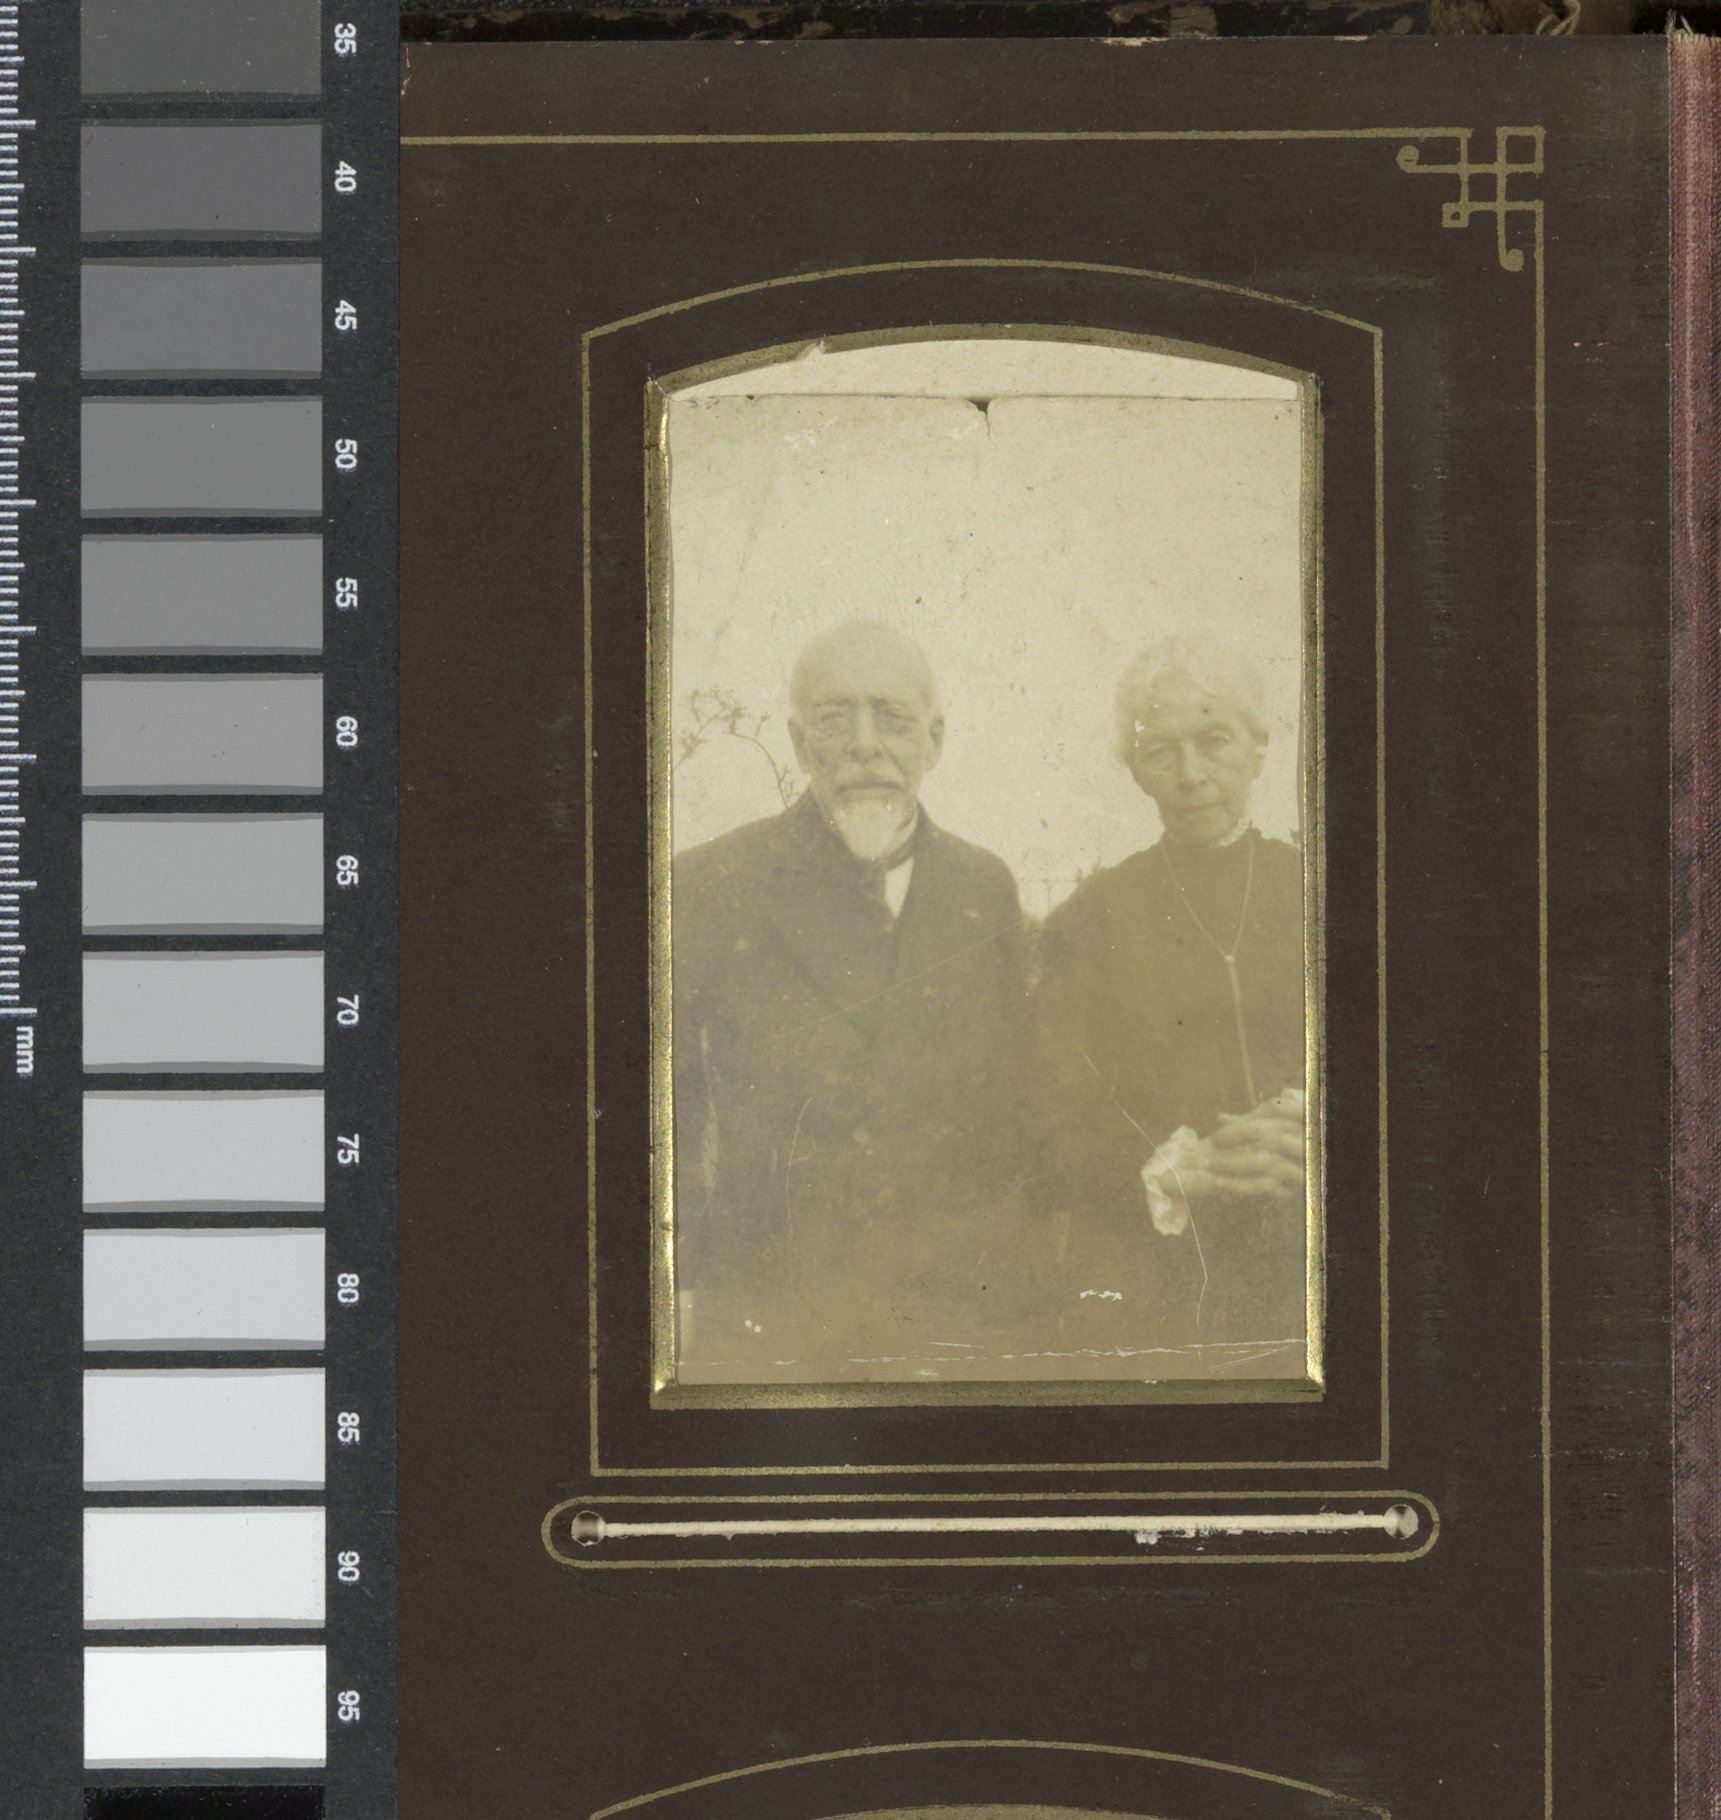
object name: album leaf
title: Portret van een man en een vrouw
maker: Anonymous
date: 1860-1890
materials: cardboard, paper, photographic support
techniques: albumen print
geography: netherlands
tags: historical persons not known by name - bb - woman, old man, marriage, married couple, 'matrimonium', old woman, historical persons not known by name, netherlands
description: Onderdeel van Fotoalbum van de families Matthes, Doorman en Van Thiel.